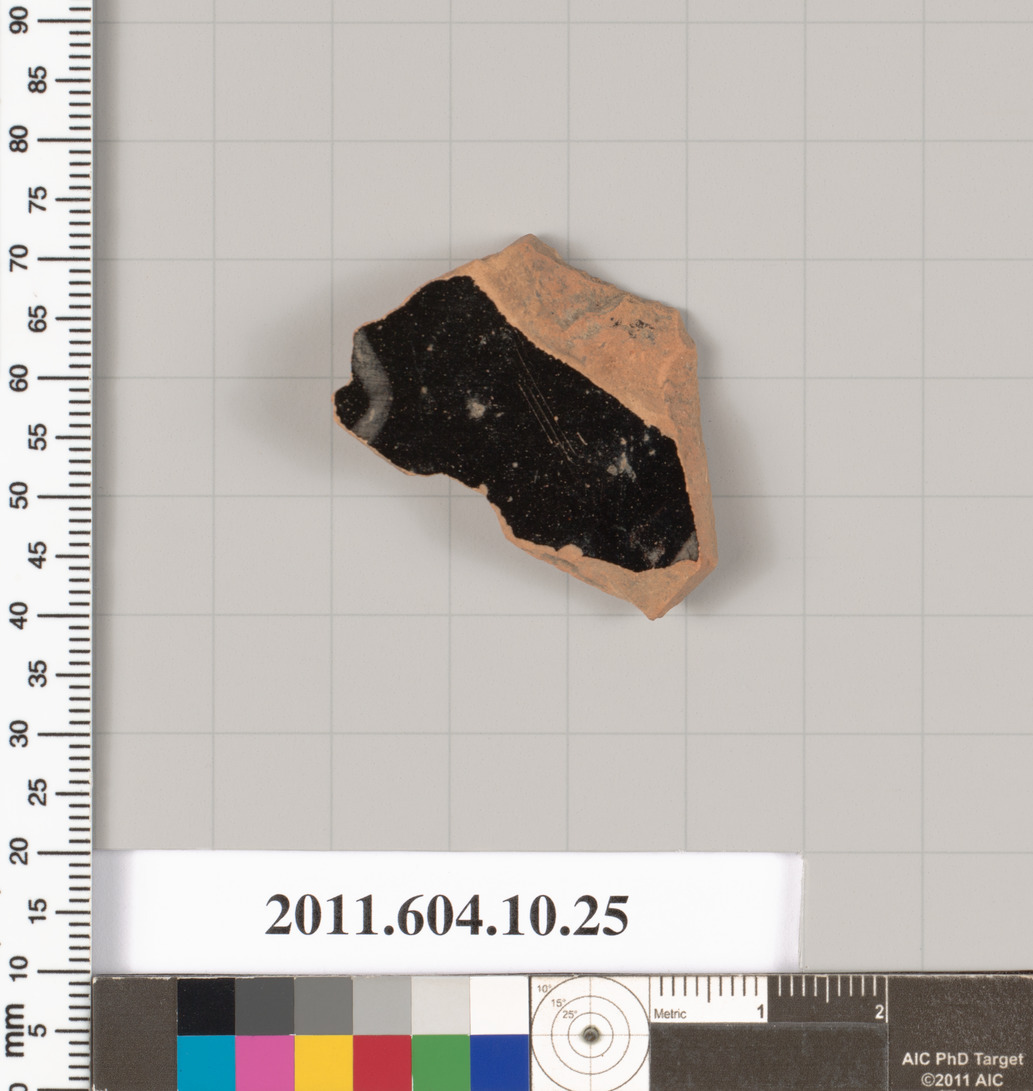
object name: kylix fragment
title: Terracotta fragment of a kylix (drinking cup)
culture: etruscan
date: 434-368 BCE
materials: terracotta